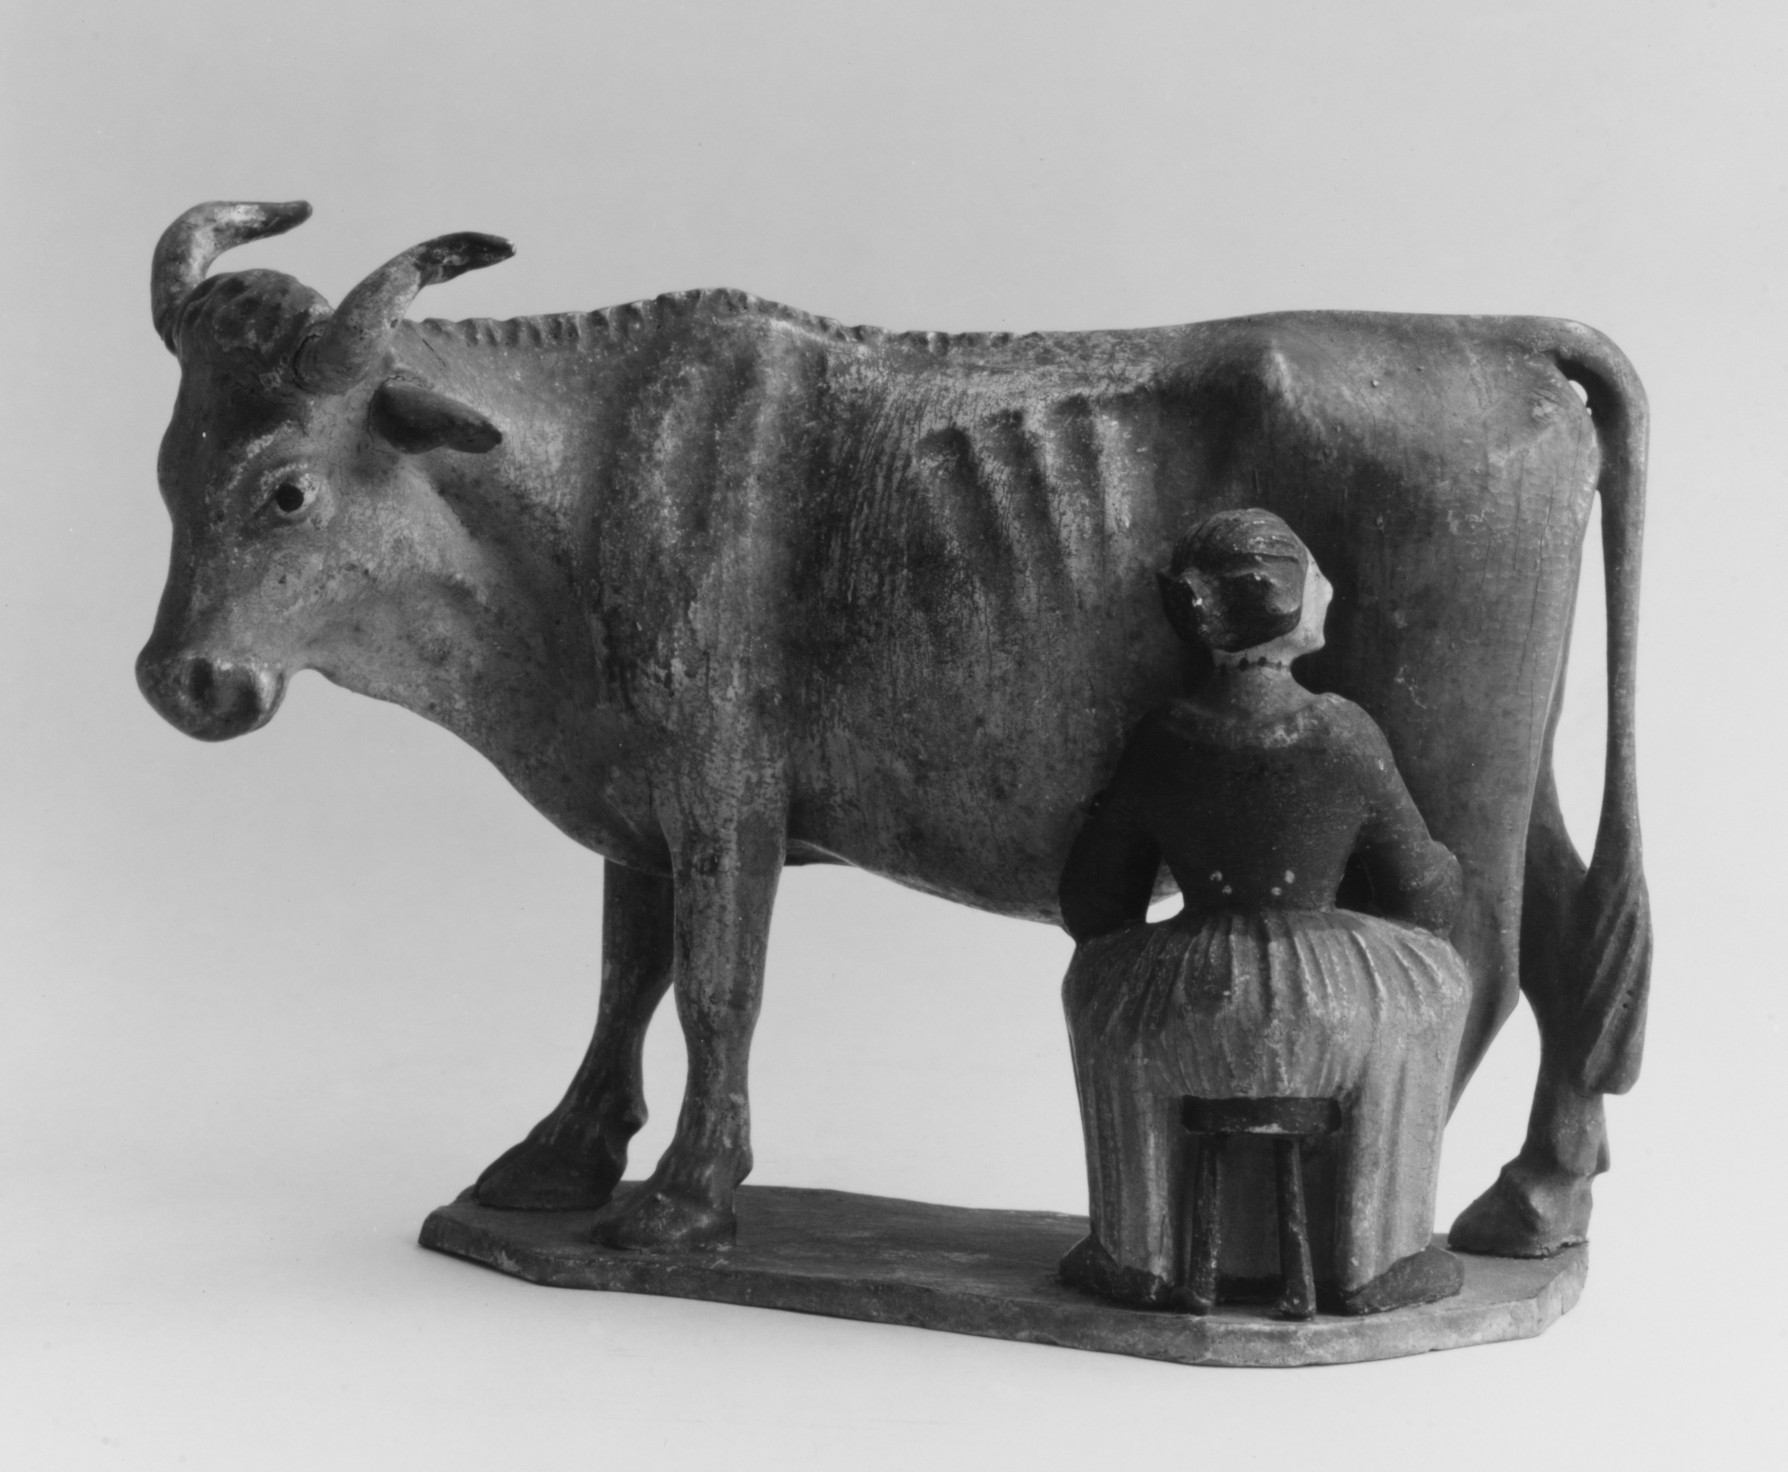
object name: statuette group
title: Girl milking a cow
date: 1701-1800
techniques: polychrome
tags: girls,cows,working